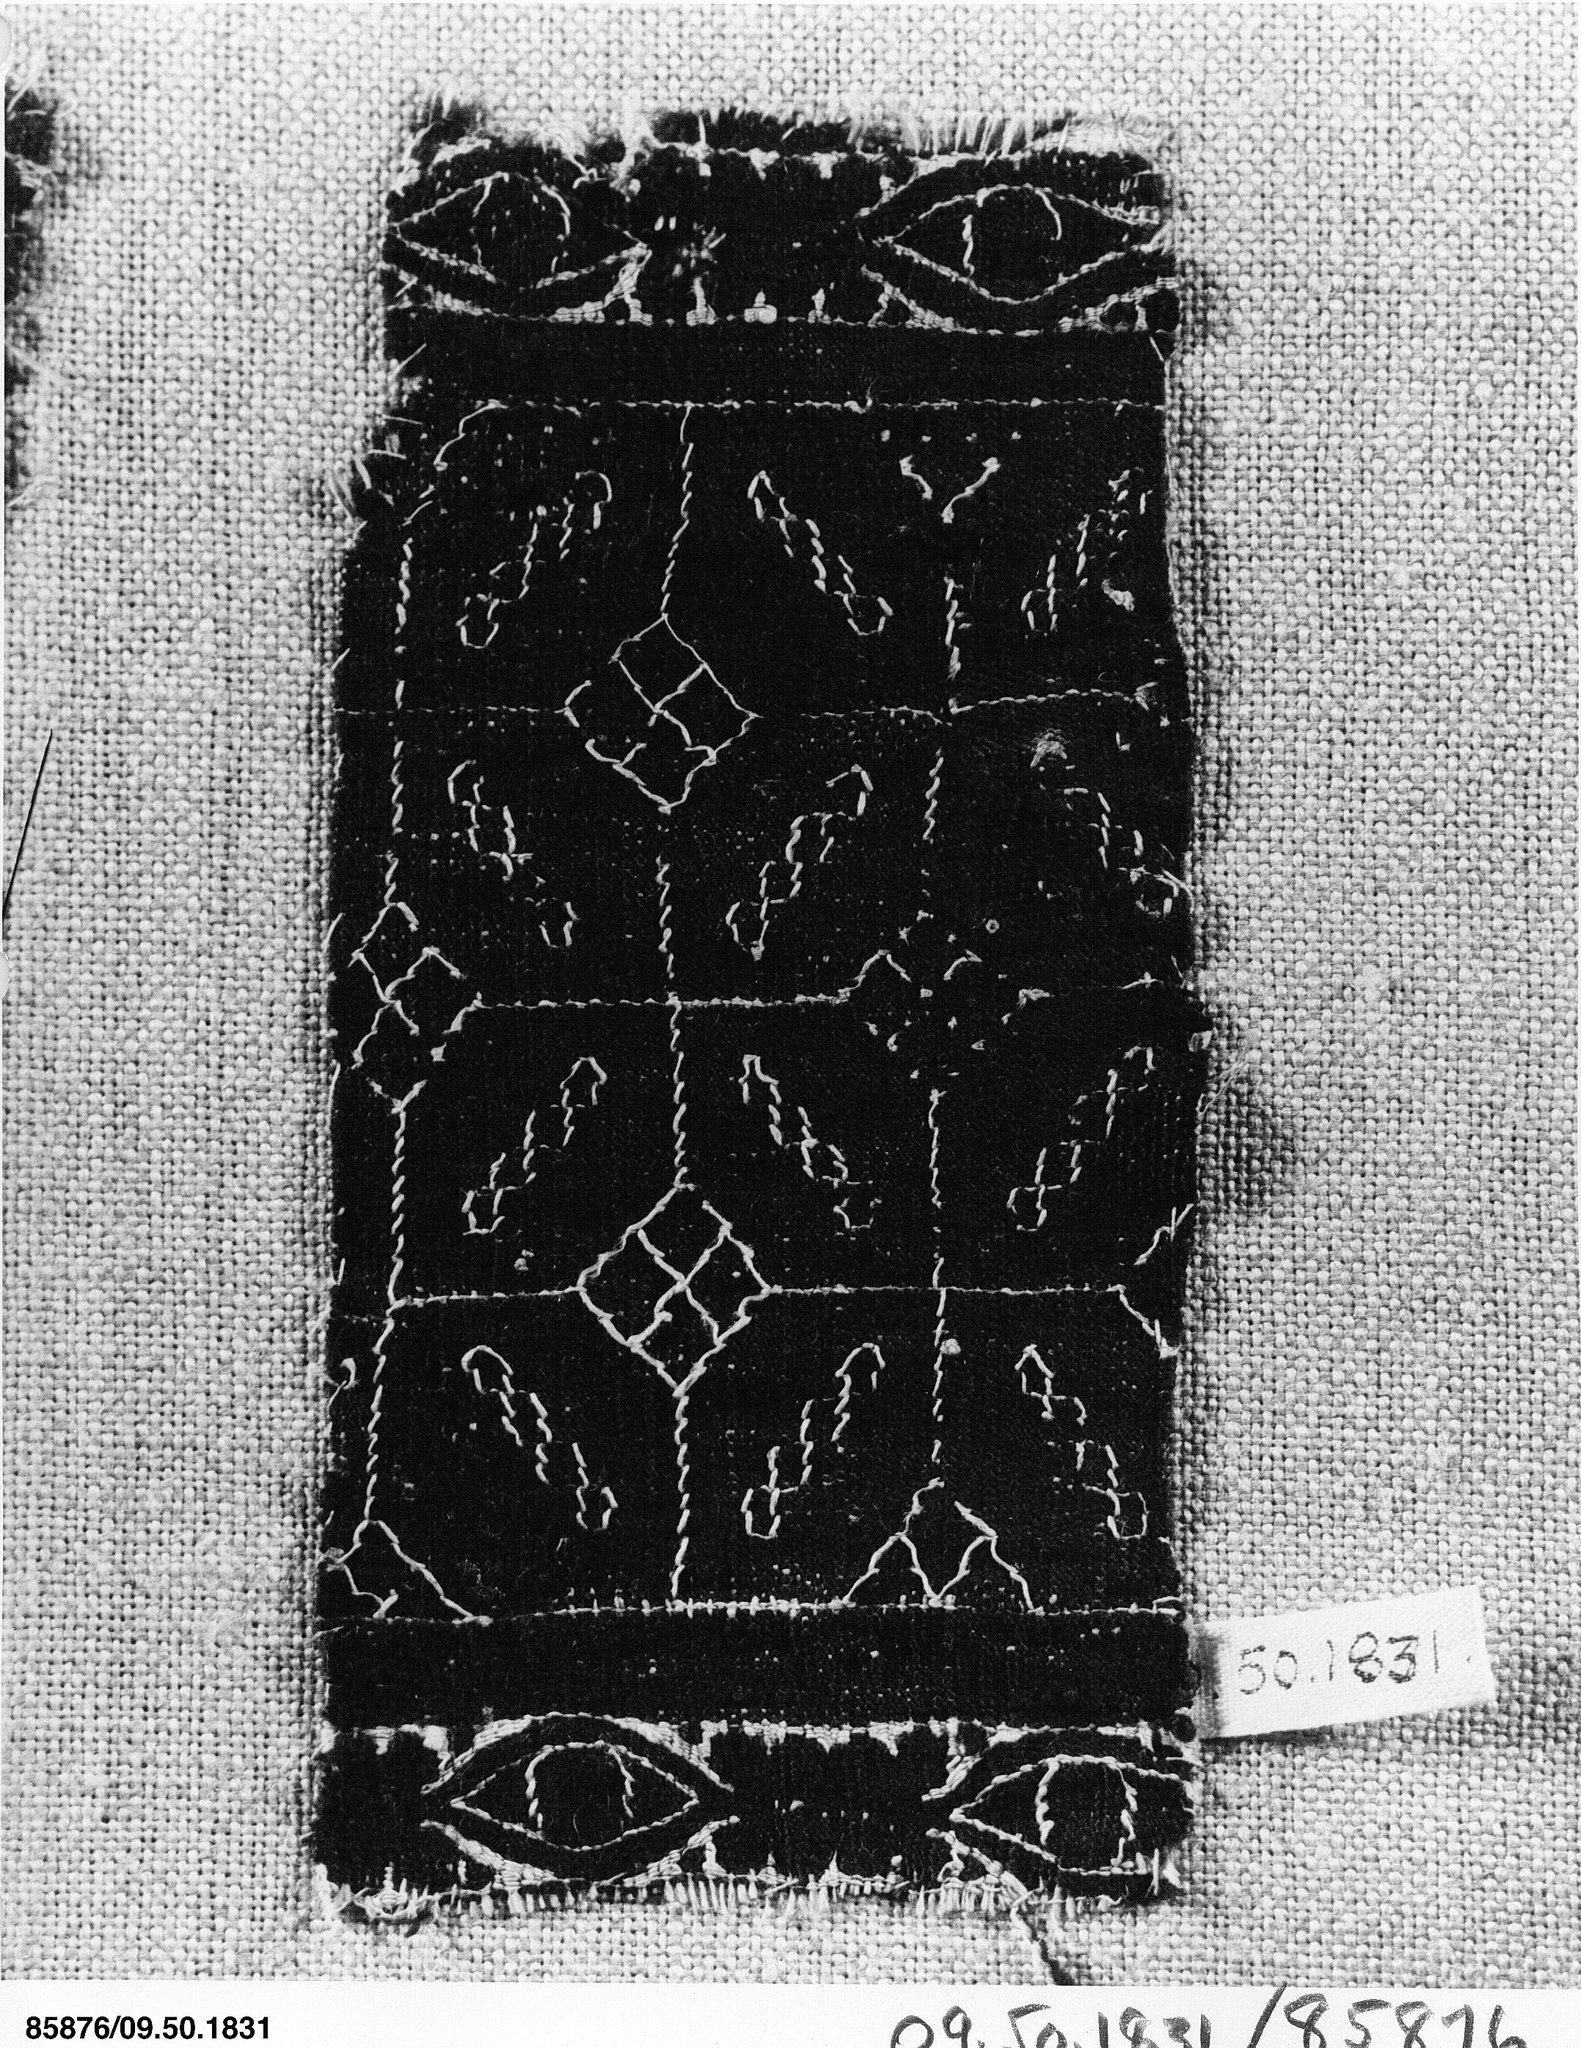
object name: band fragment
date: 201-400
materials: linen, wool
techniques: weave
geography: egypt